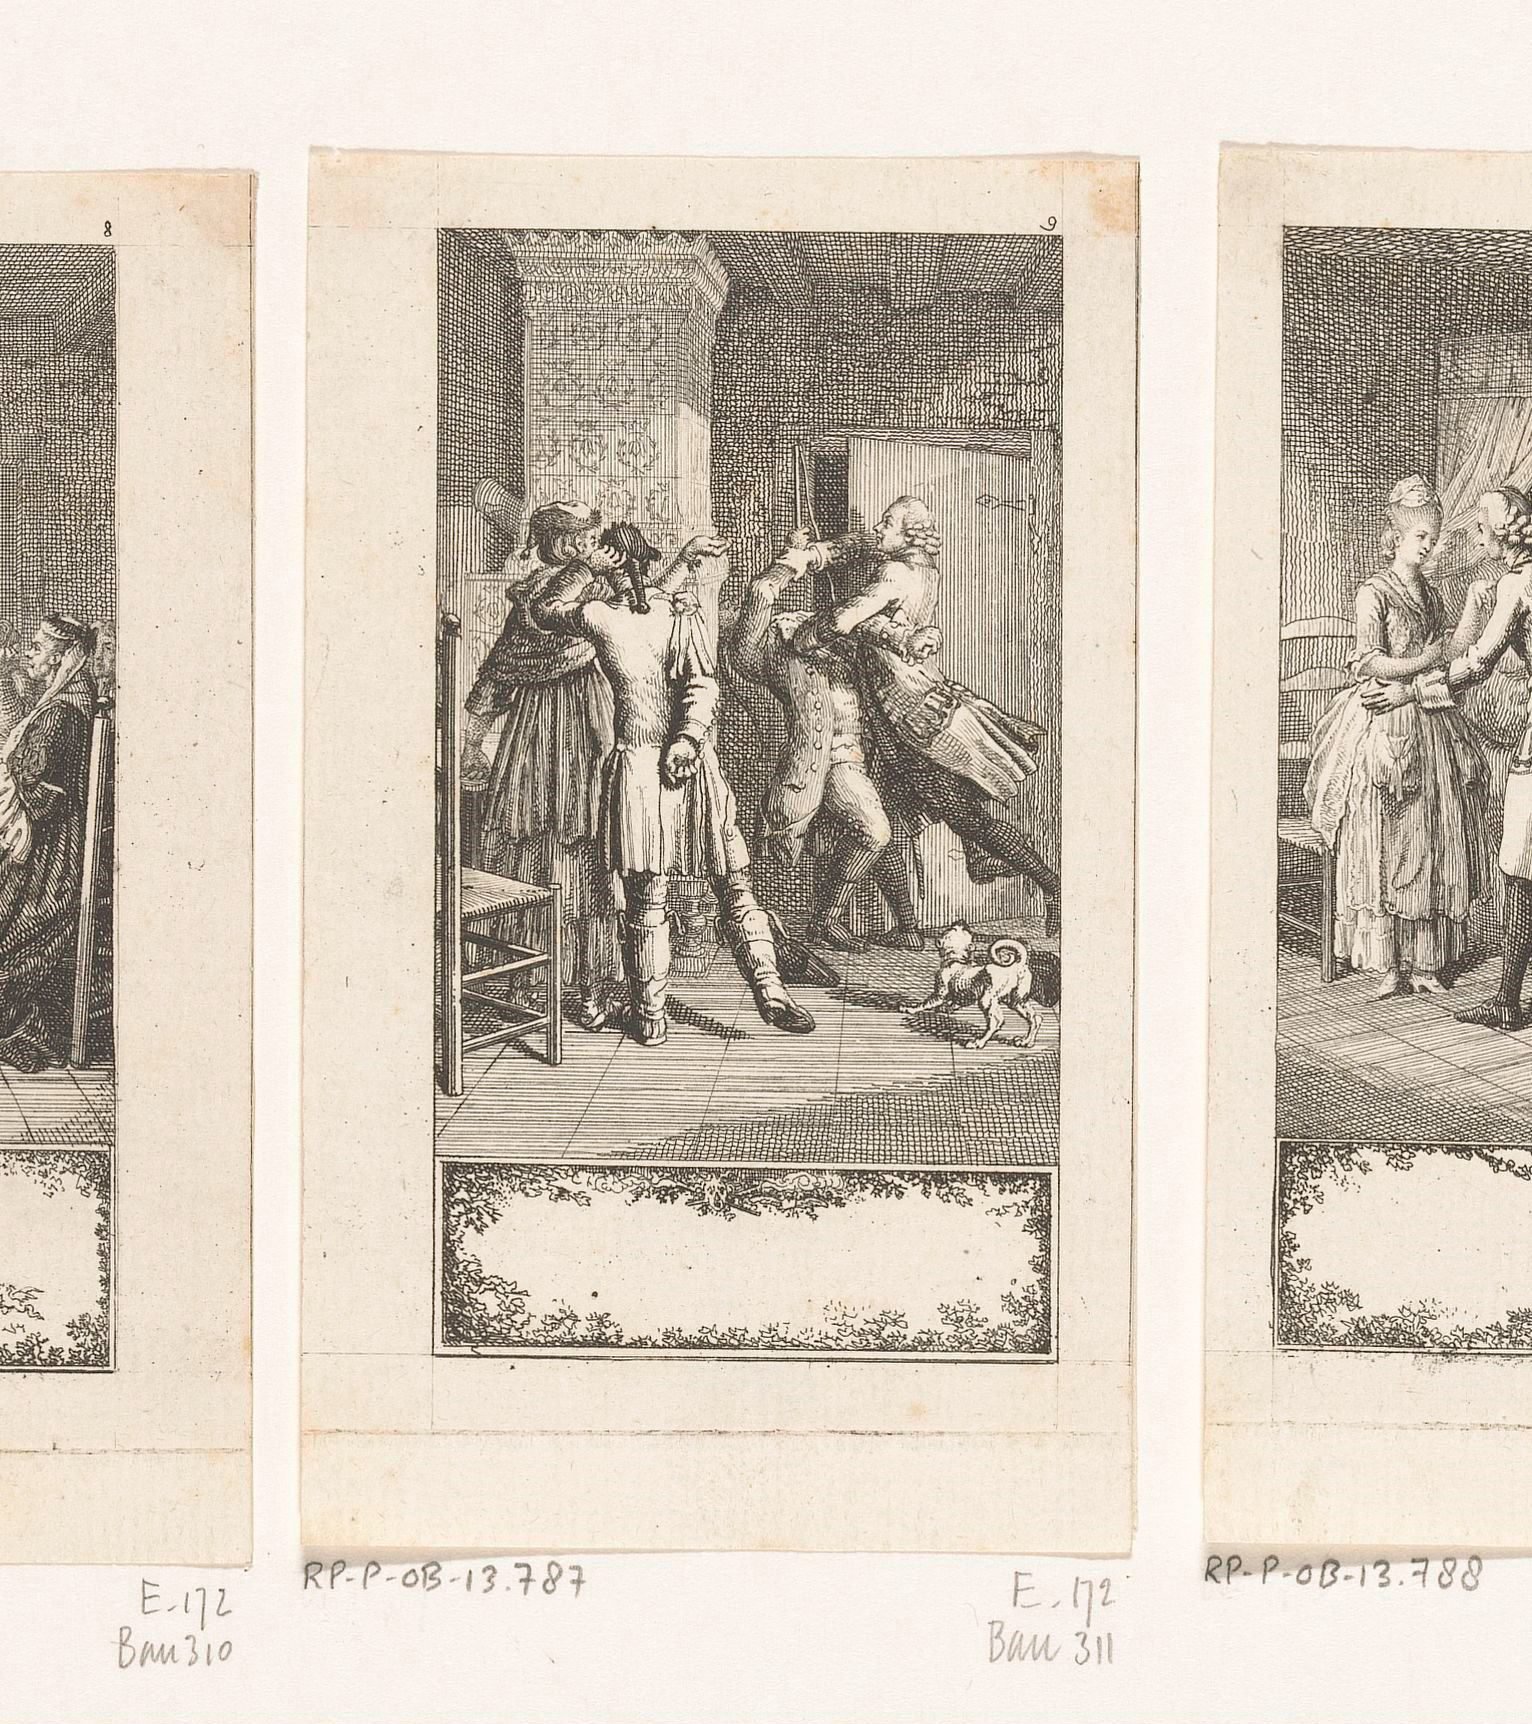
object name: print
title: Pastor Gros in gevecht met de man van Marjorin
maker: daniel nikolaus chodowiecki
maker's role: draughtsman, print maker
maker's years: 1726-1801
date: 1776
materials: paper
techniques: etching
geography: berlin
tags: literature, fighting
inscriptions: collector's mark: Lugt 2228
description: Negende scène uit een serie van twaalf scènes die de 'Geschichte des Predigers Gros' illustreren, onderdeel van 'Sophiens Reise von Memel nach Sachsen' door Johann Timotheus Hermes. Pastor Gros von Haberstroh heet eigenlijk Karl Wagner en is de legitieme zoon van Frau E., de pleegmoeder van Sophie. Hij bedient zich ook van het alias Feind. De scènes werden op een plaat geëtst. Een latere staat van deze serie is gebruikt in: Gothaischer Hof Kalender zum Nutzen und Vergnügen eingerichtet auf das Jahr 1778. Gotha, C.W. Ettinger, s.a.